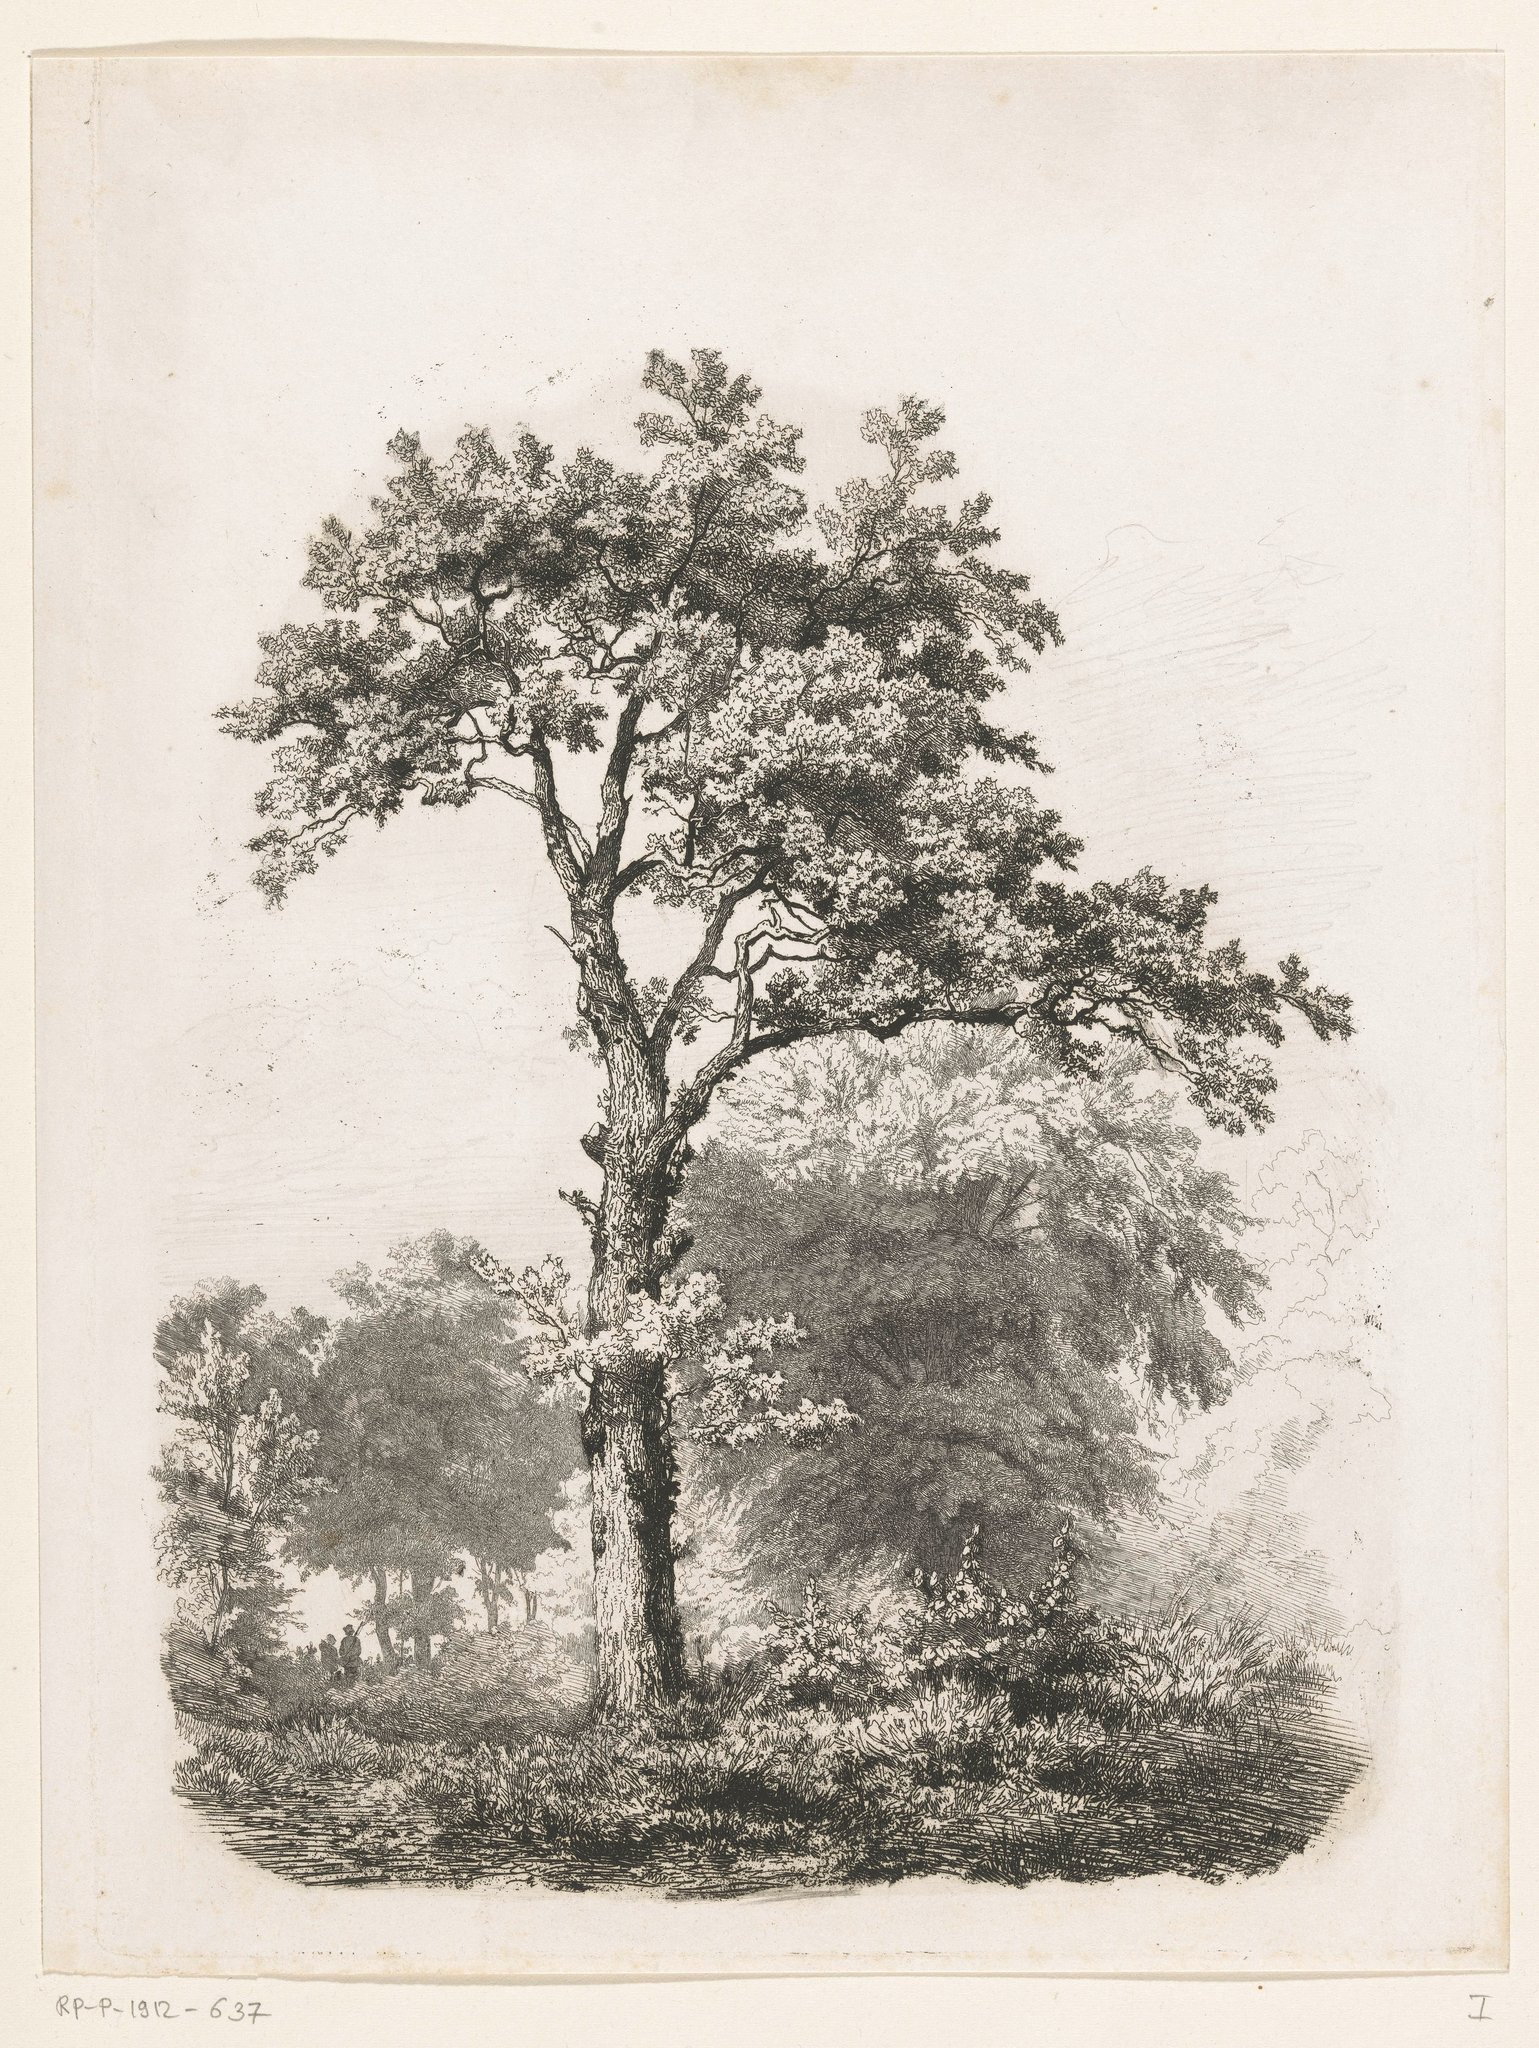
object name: print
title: Vijf etsproeven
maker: pierre louis dubourcq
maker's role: draughtsman, painter, print maker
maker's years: 1815-1873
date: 1840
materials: paper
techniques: etching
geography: netherlands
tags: trees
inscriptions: collector's mark: Lugt 2228